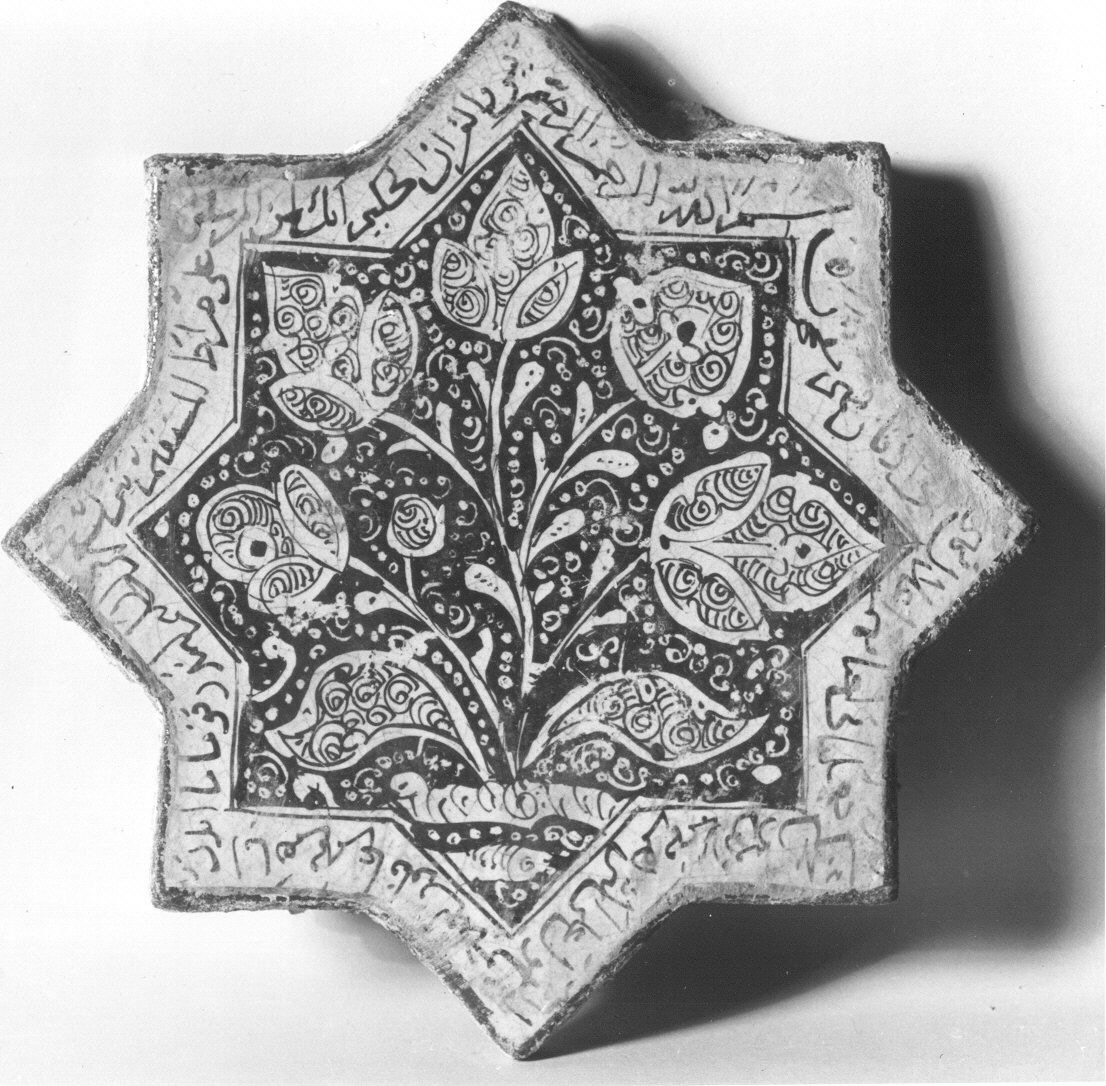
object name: tile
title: Star-Shaped Tile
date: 1260-1270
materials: glaze, stonepaste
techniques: luster painting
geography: iran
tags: stars